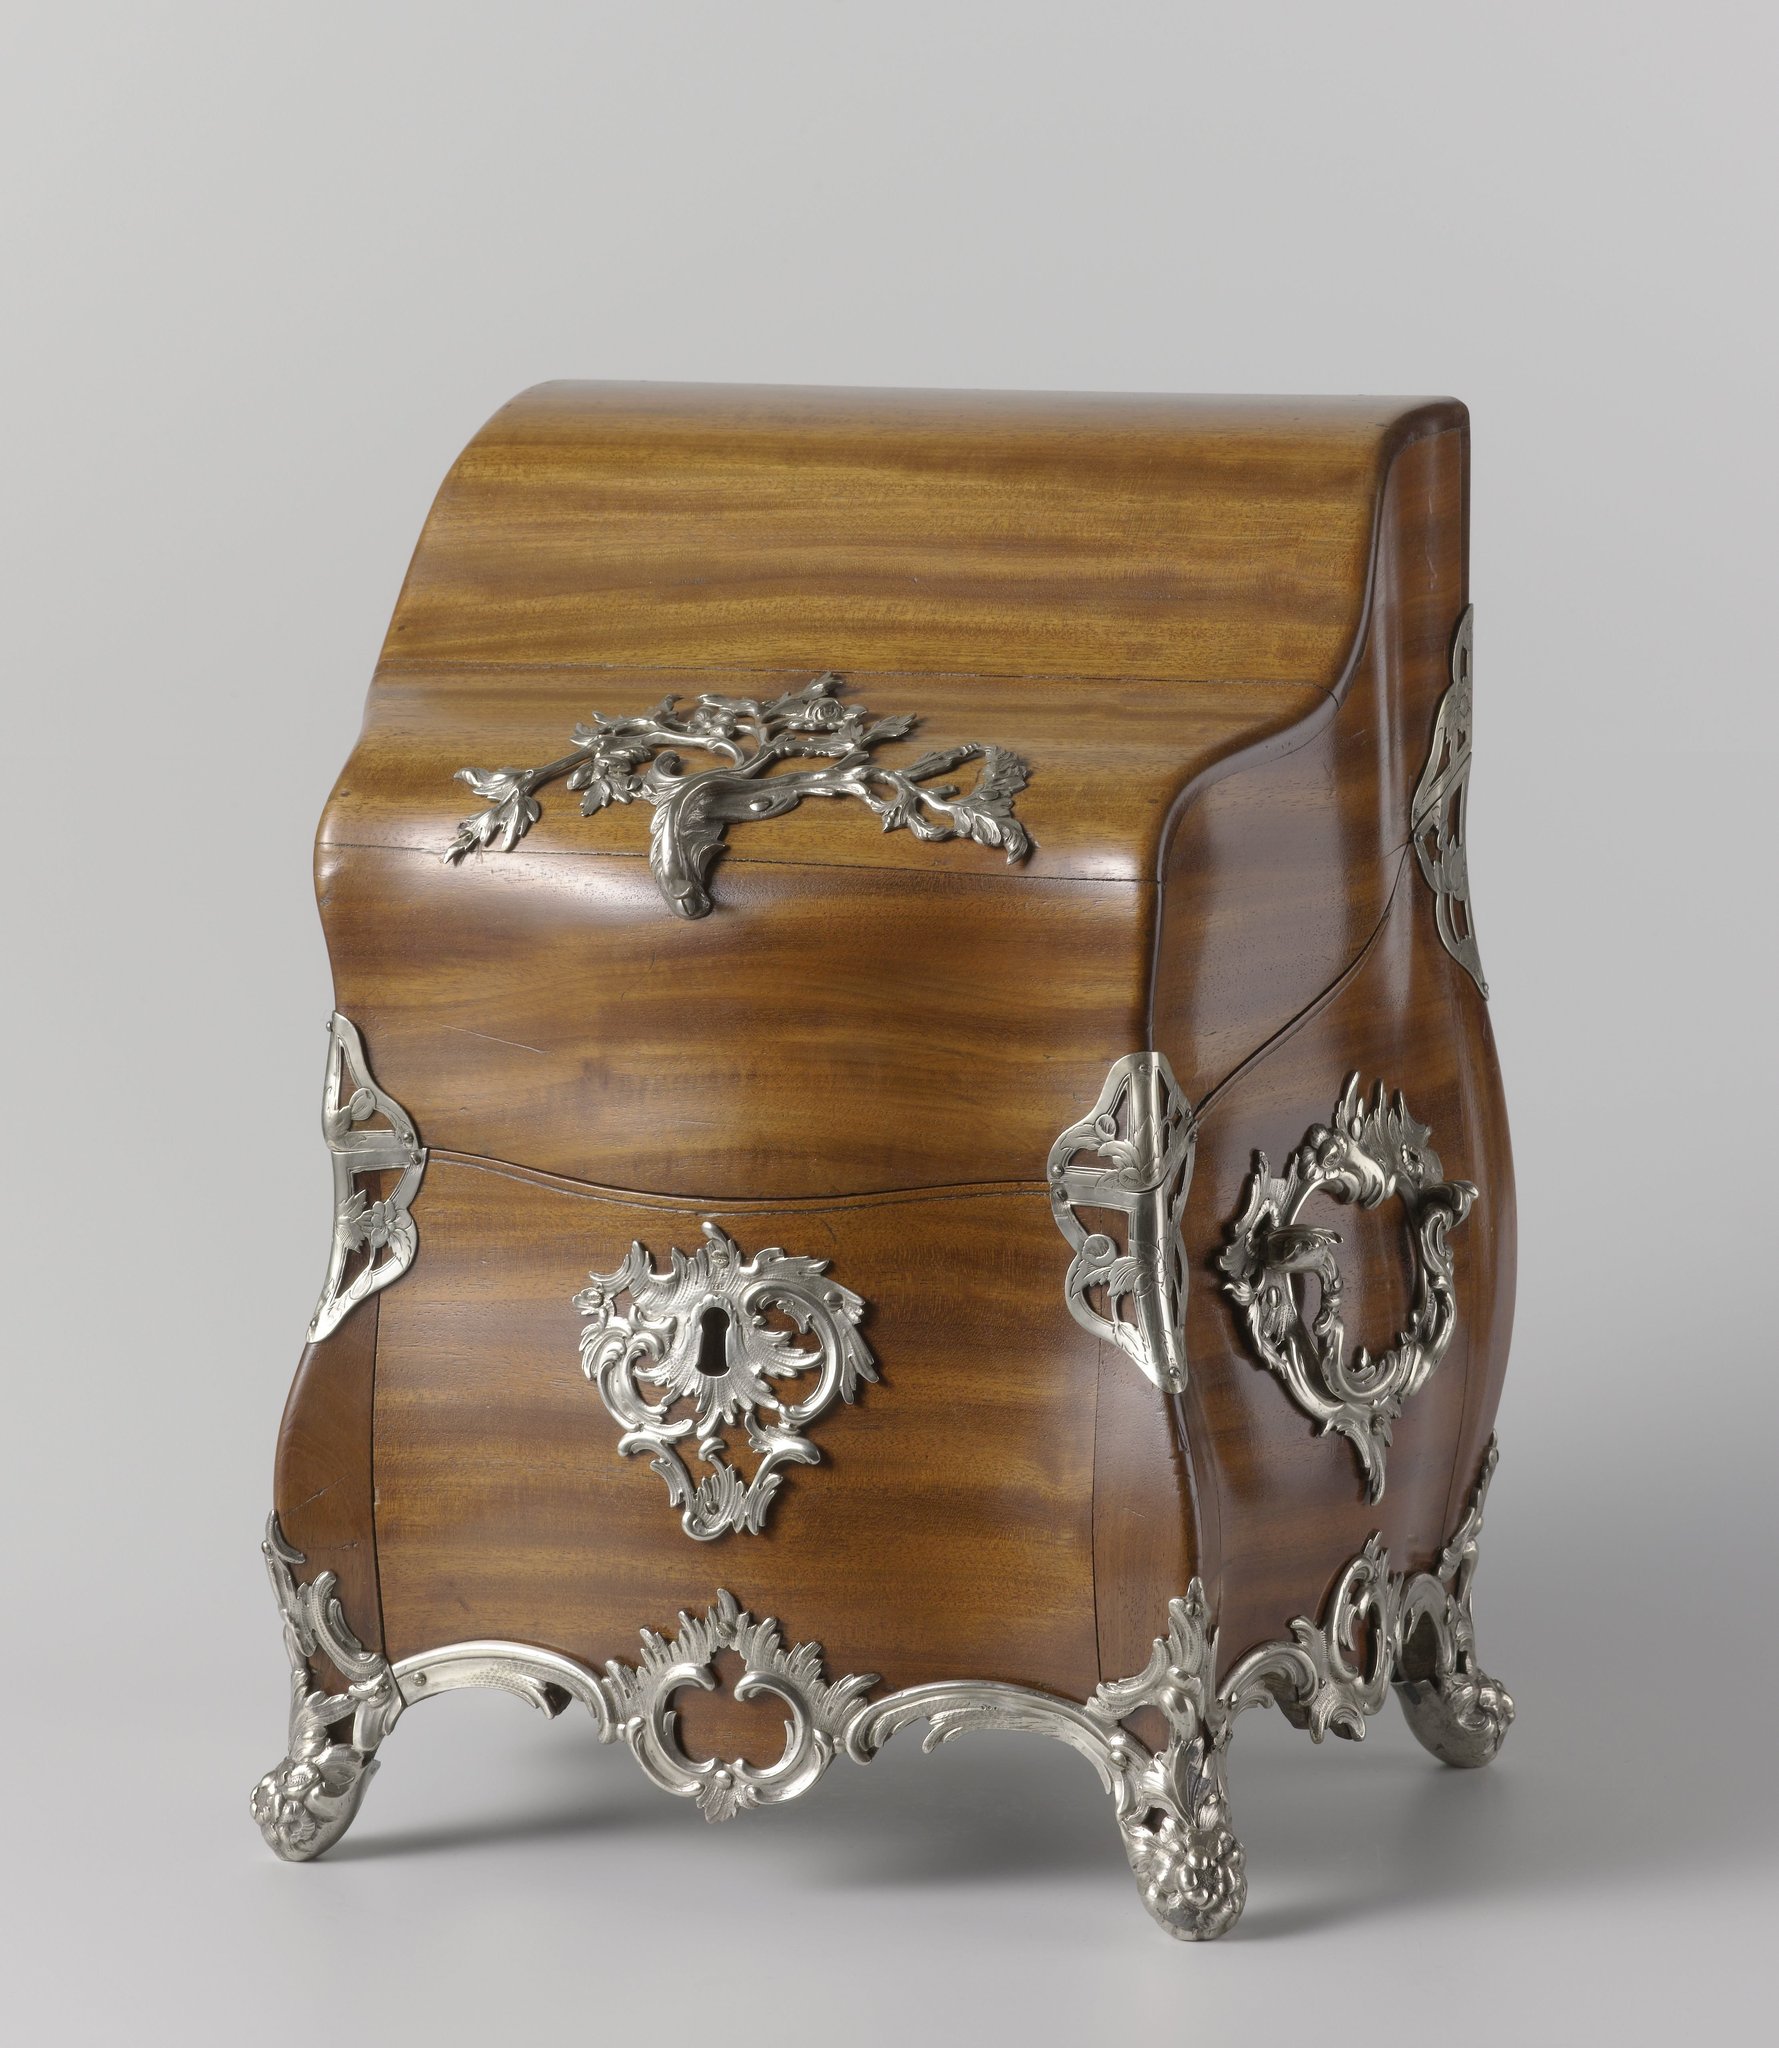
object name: cutlery box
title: Cutlery canteen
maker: johannes schiotling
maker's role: silversmith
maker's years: 1730-1799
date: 1772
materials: cordage, wood, silk, silver, velvet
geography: amsterdam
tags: rocaille ornament, ornament ~ cartouche, ornament derived from plant forms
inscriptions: date letter: ‘N’, maker's mark, town mark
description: Keeping silver knives, spoons and forks in wooden cases or canteens came into fashion during the second half of the 18th century. This particular one was designed as a miniature piece of Rococo furniture, with rich mounts like those on an expensive commode.